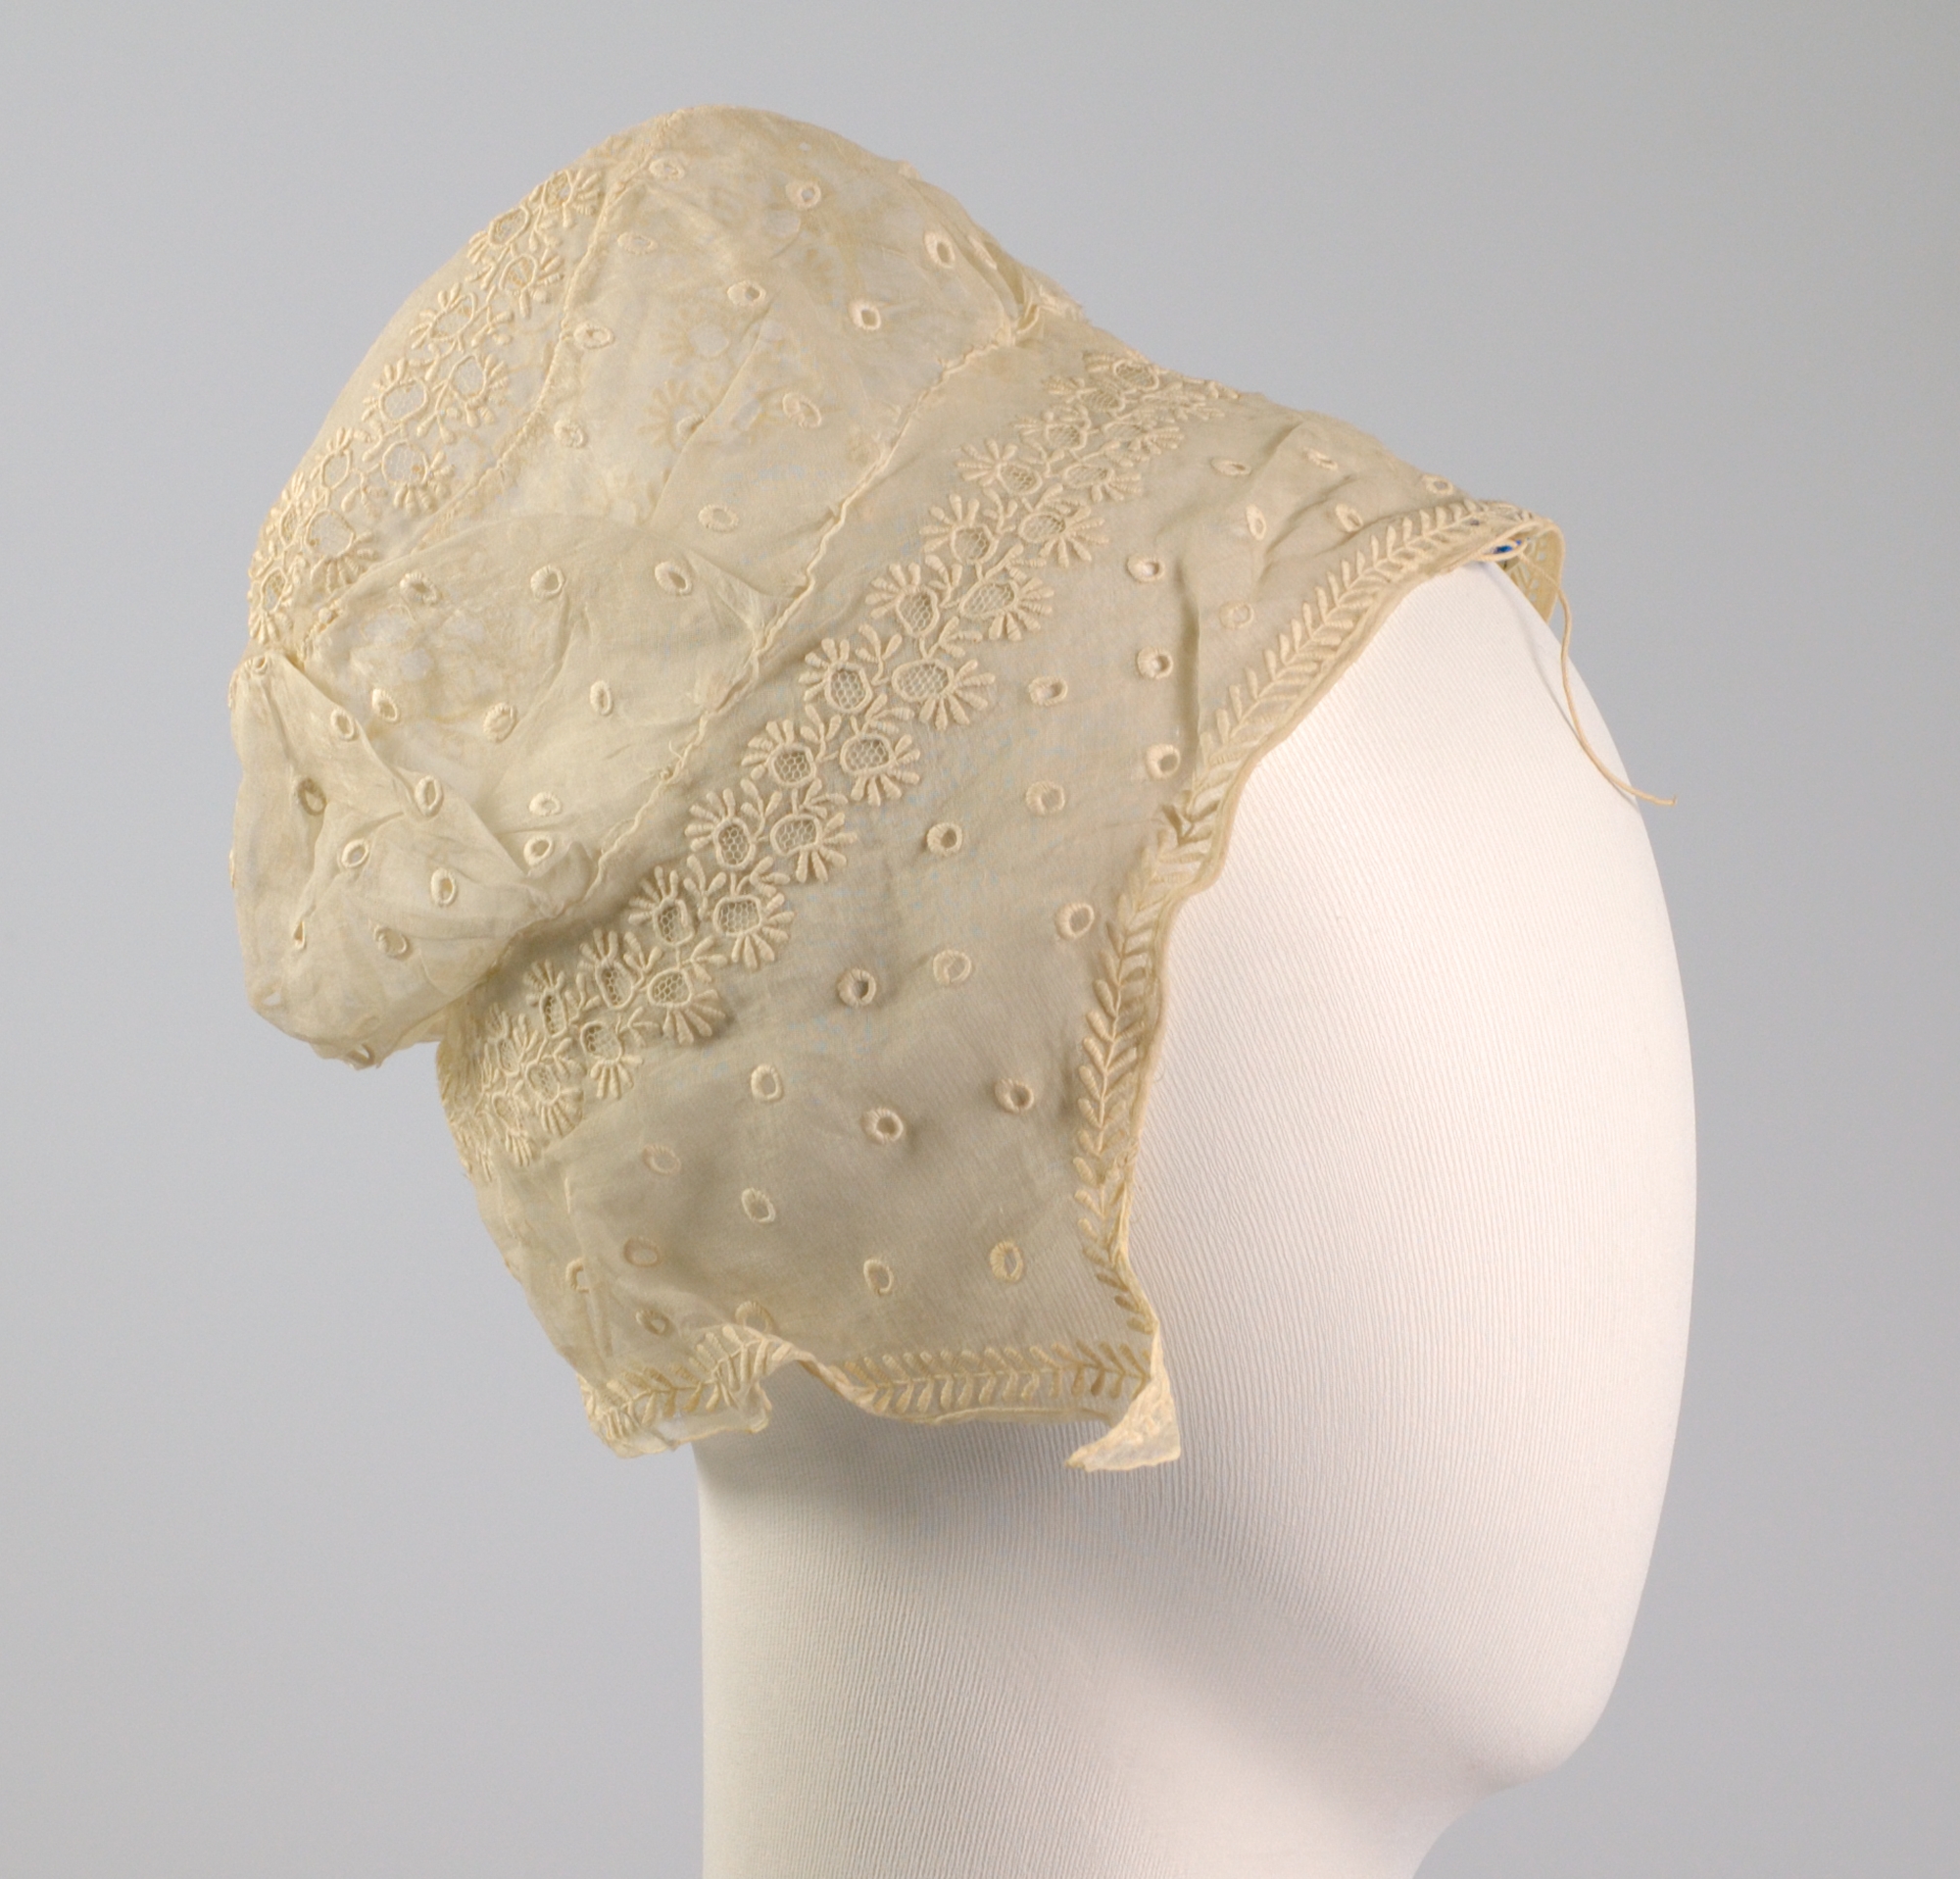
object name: cap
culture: american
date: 1830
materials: cotton